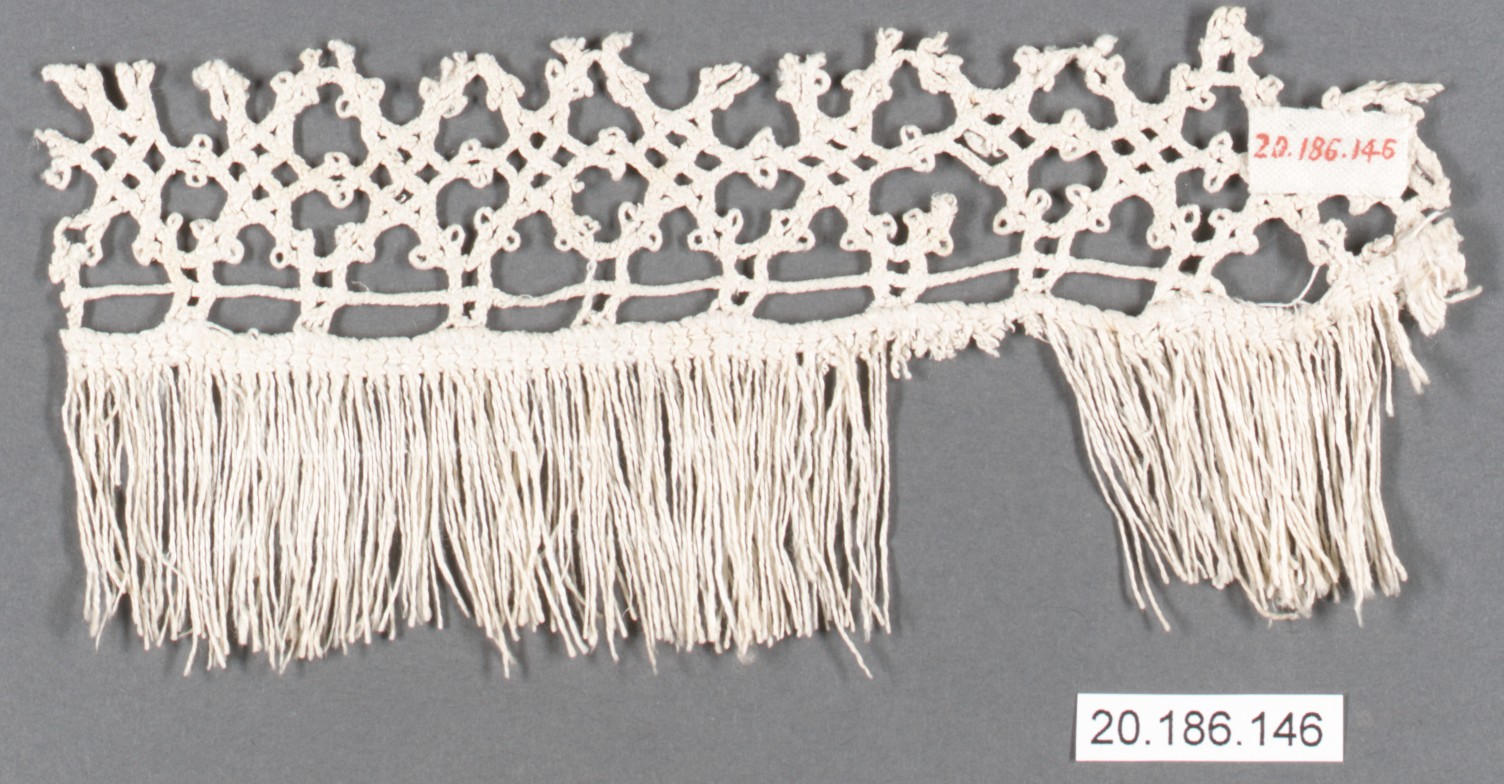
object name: fragment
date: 1501-1600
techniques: lace